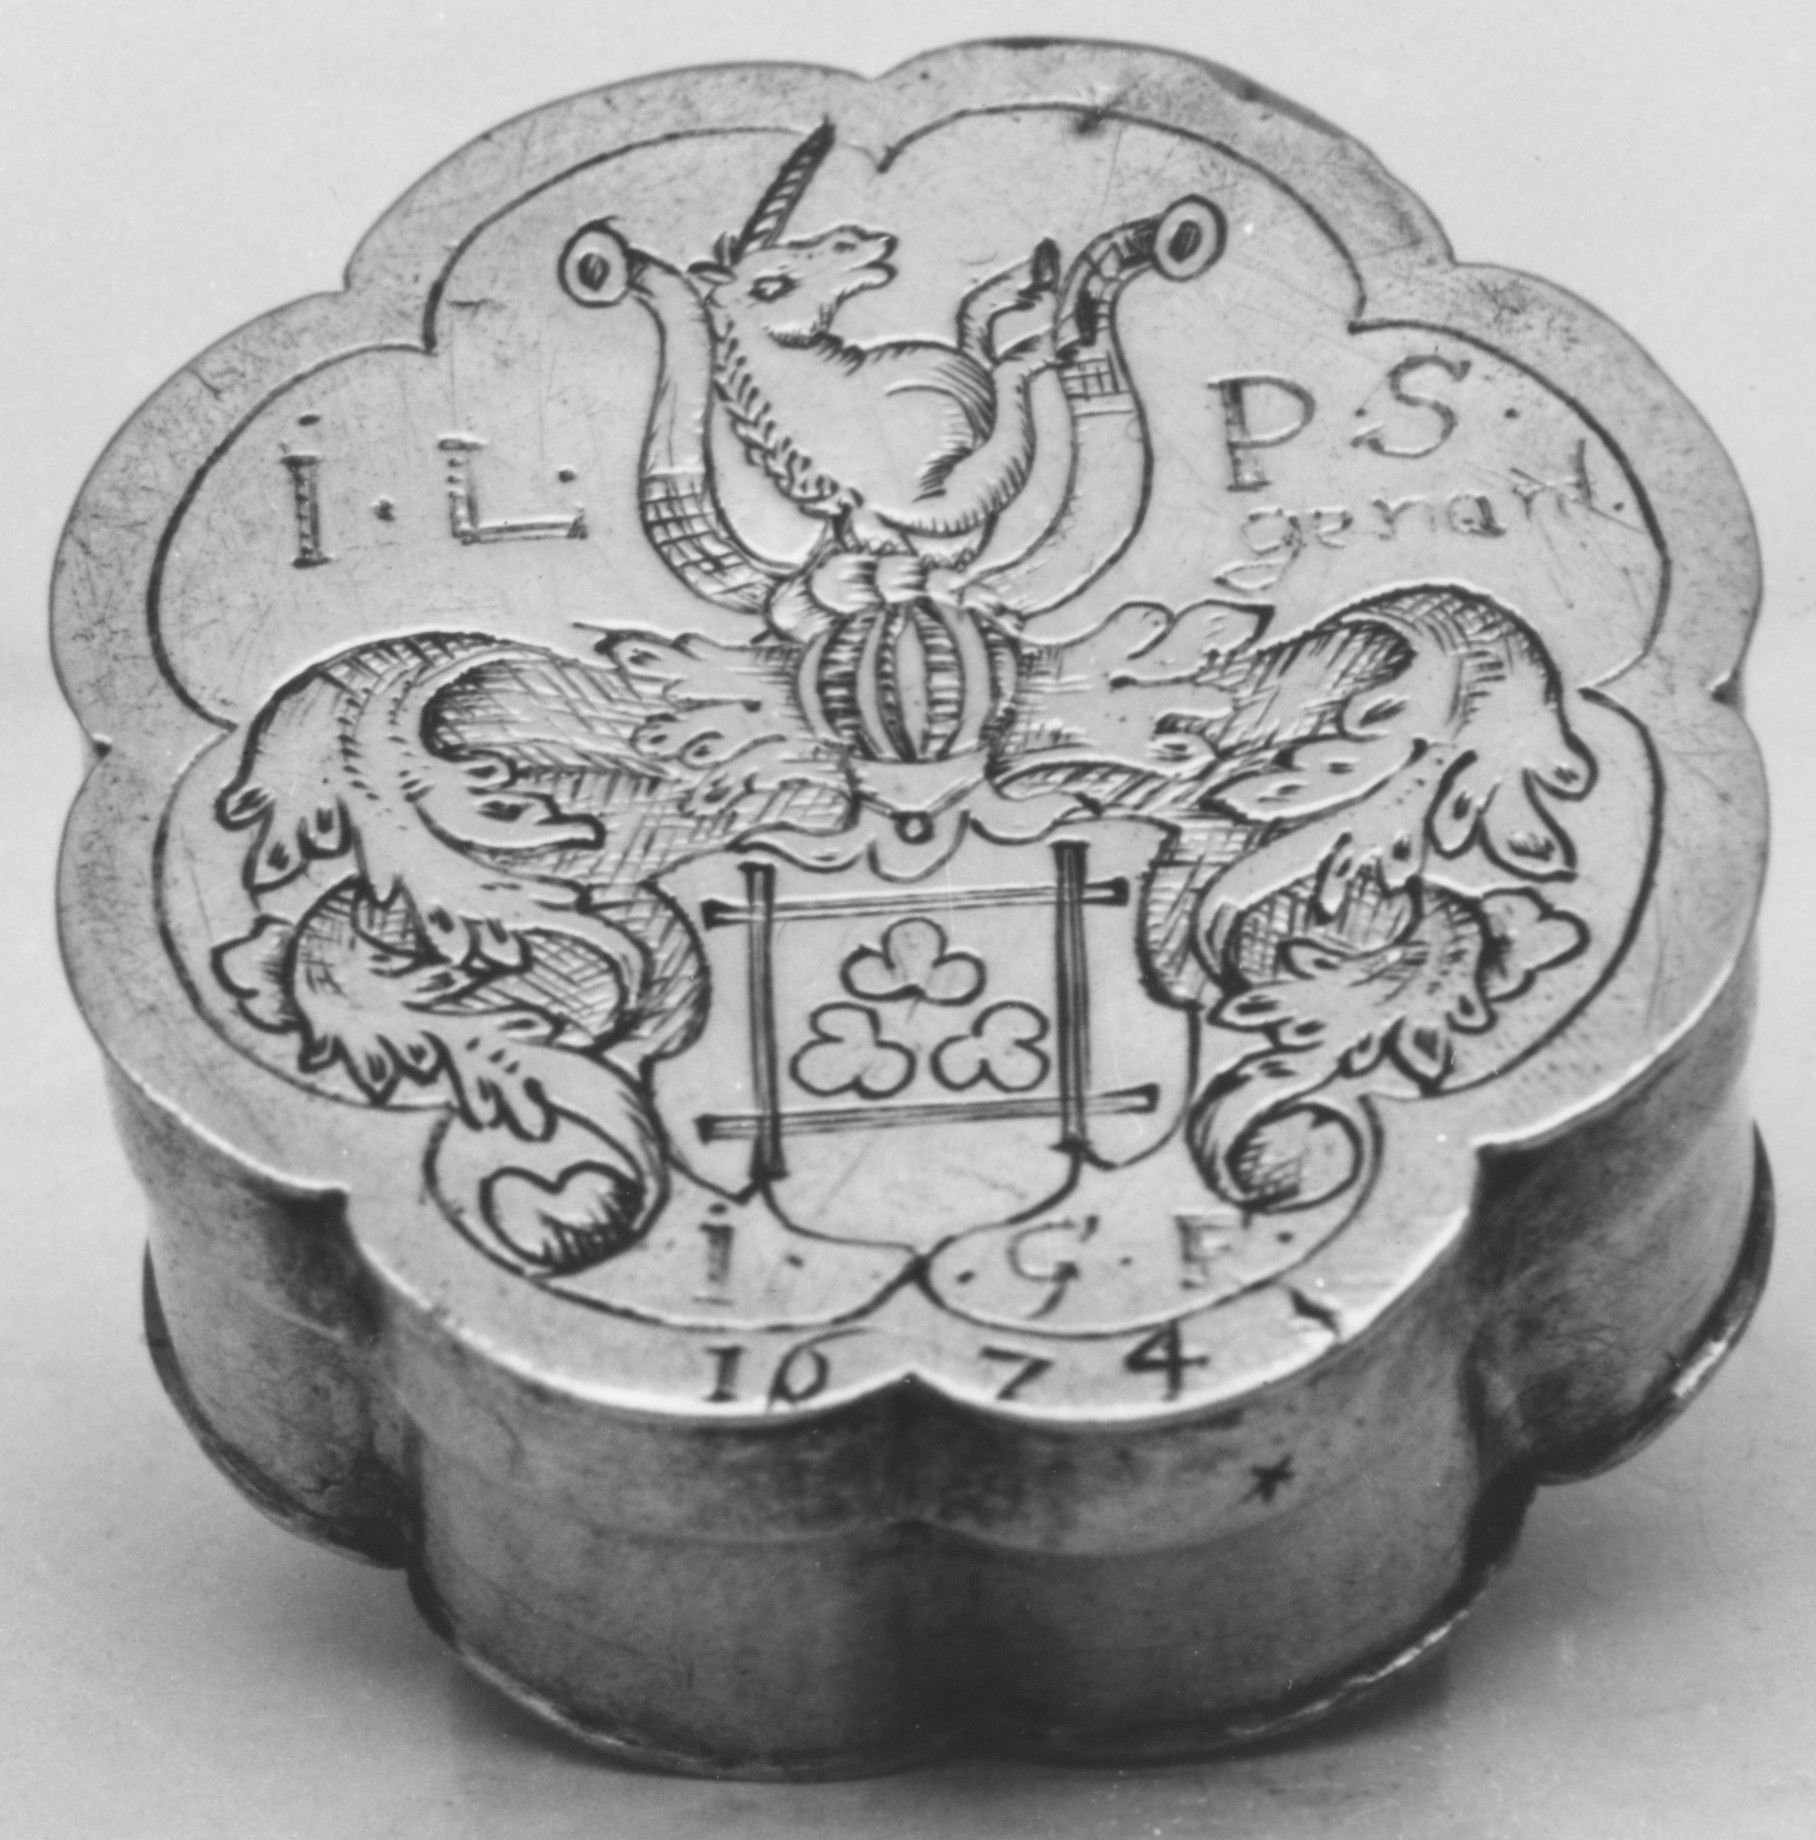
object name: box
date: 1674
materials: silver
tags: coat of arms